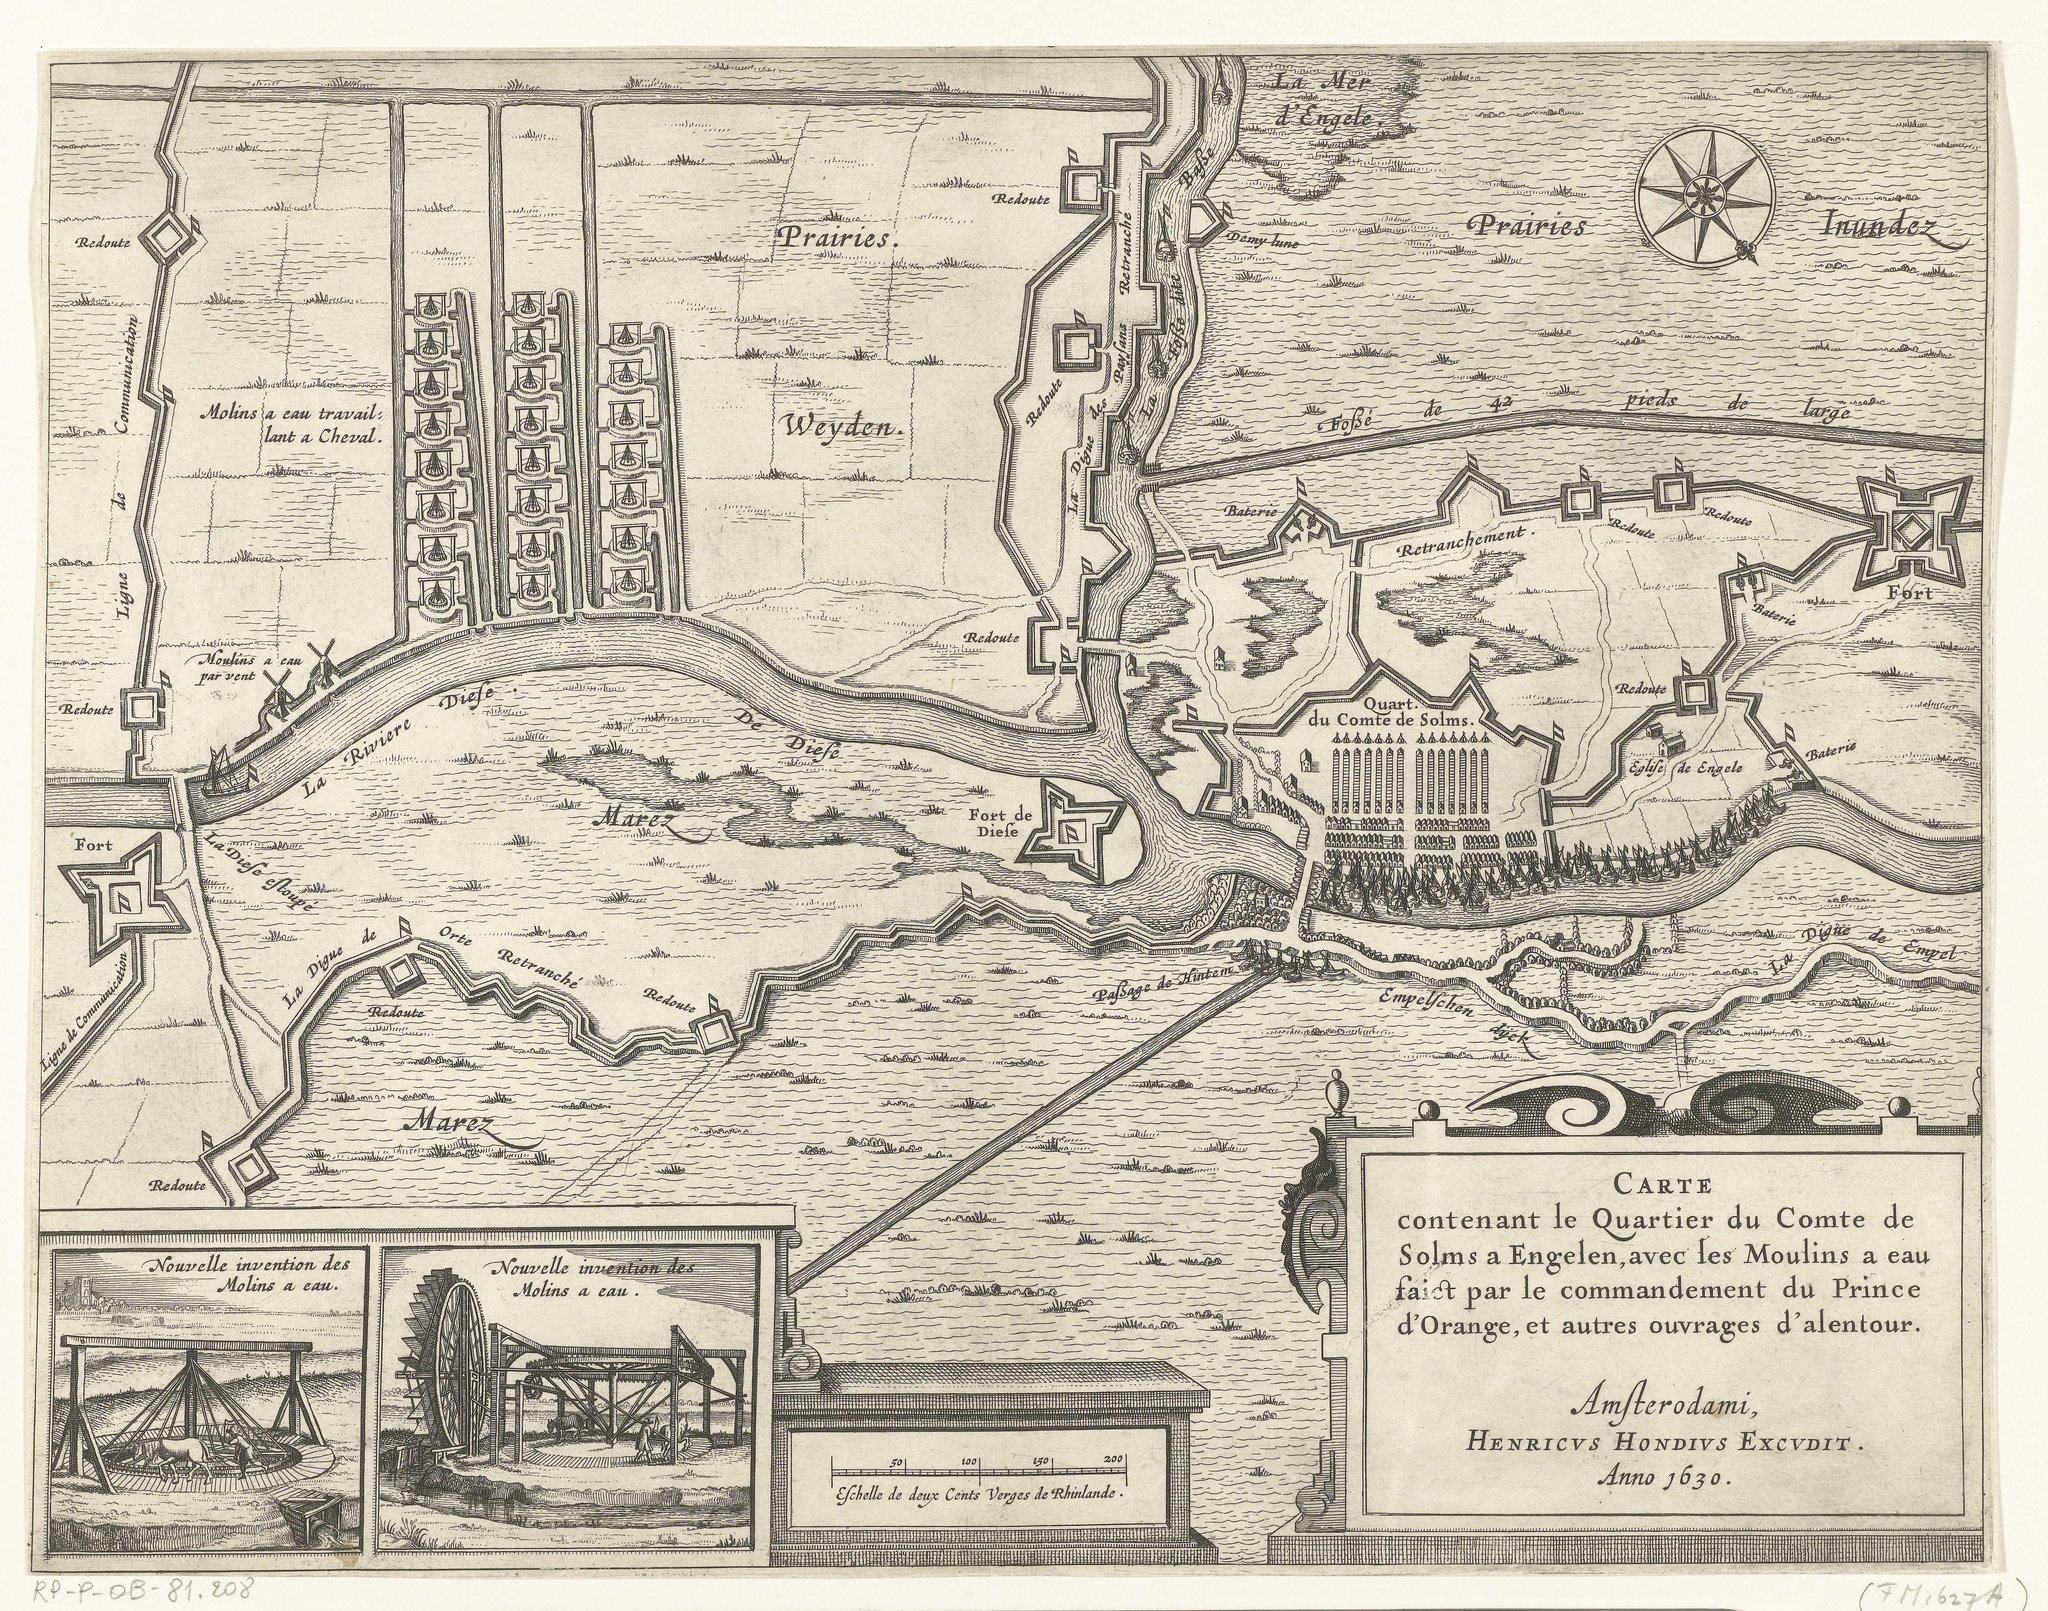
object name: print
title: Zeven deelkaarten betreffende het beleg van Den Bosch in 1629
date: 1630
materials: paper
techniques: etching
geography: northern netherlands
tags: delft, the hague, frederick henry (prince of orange), maps of separate countries or regions, fortifications, military engineering, den bosch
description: Kaart van het legerkwartier van de graaf van Solms met een vloot op de Dieze. Linksboven op de kaart de watermolens. Linksonder twee details met de twee typen molens. Onderdeel van het beleg van Den Bosch door het Staatse leger onder Frederik Hendrik, van 1 mei tot 17 september 1629. Opschriften in de voorstelling in het Frans en Nederlands. Behoort waarschijnlijk bij de grote kaart van het beleg.